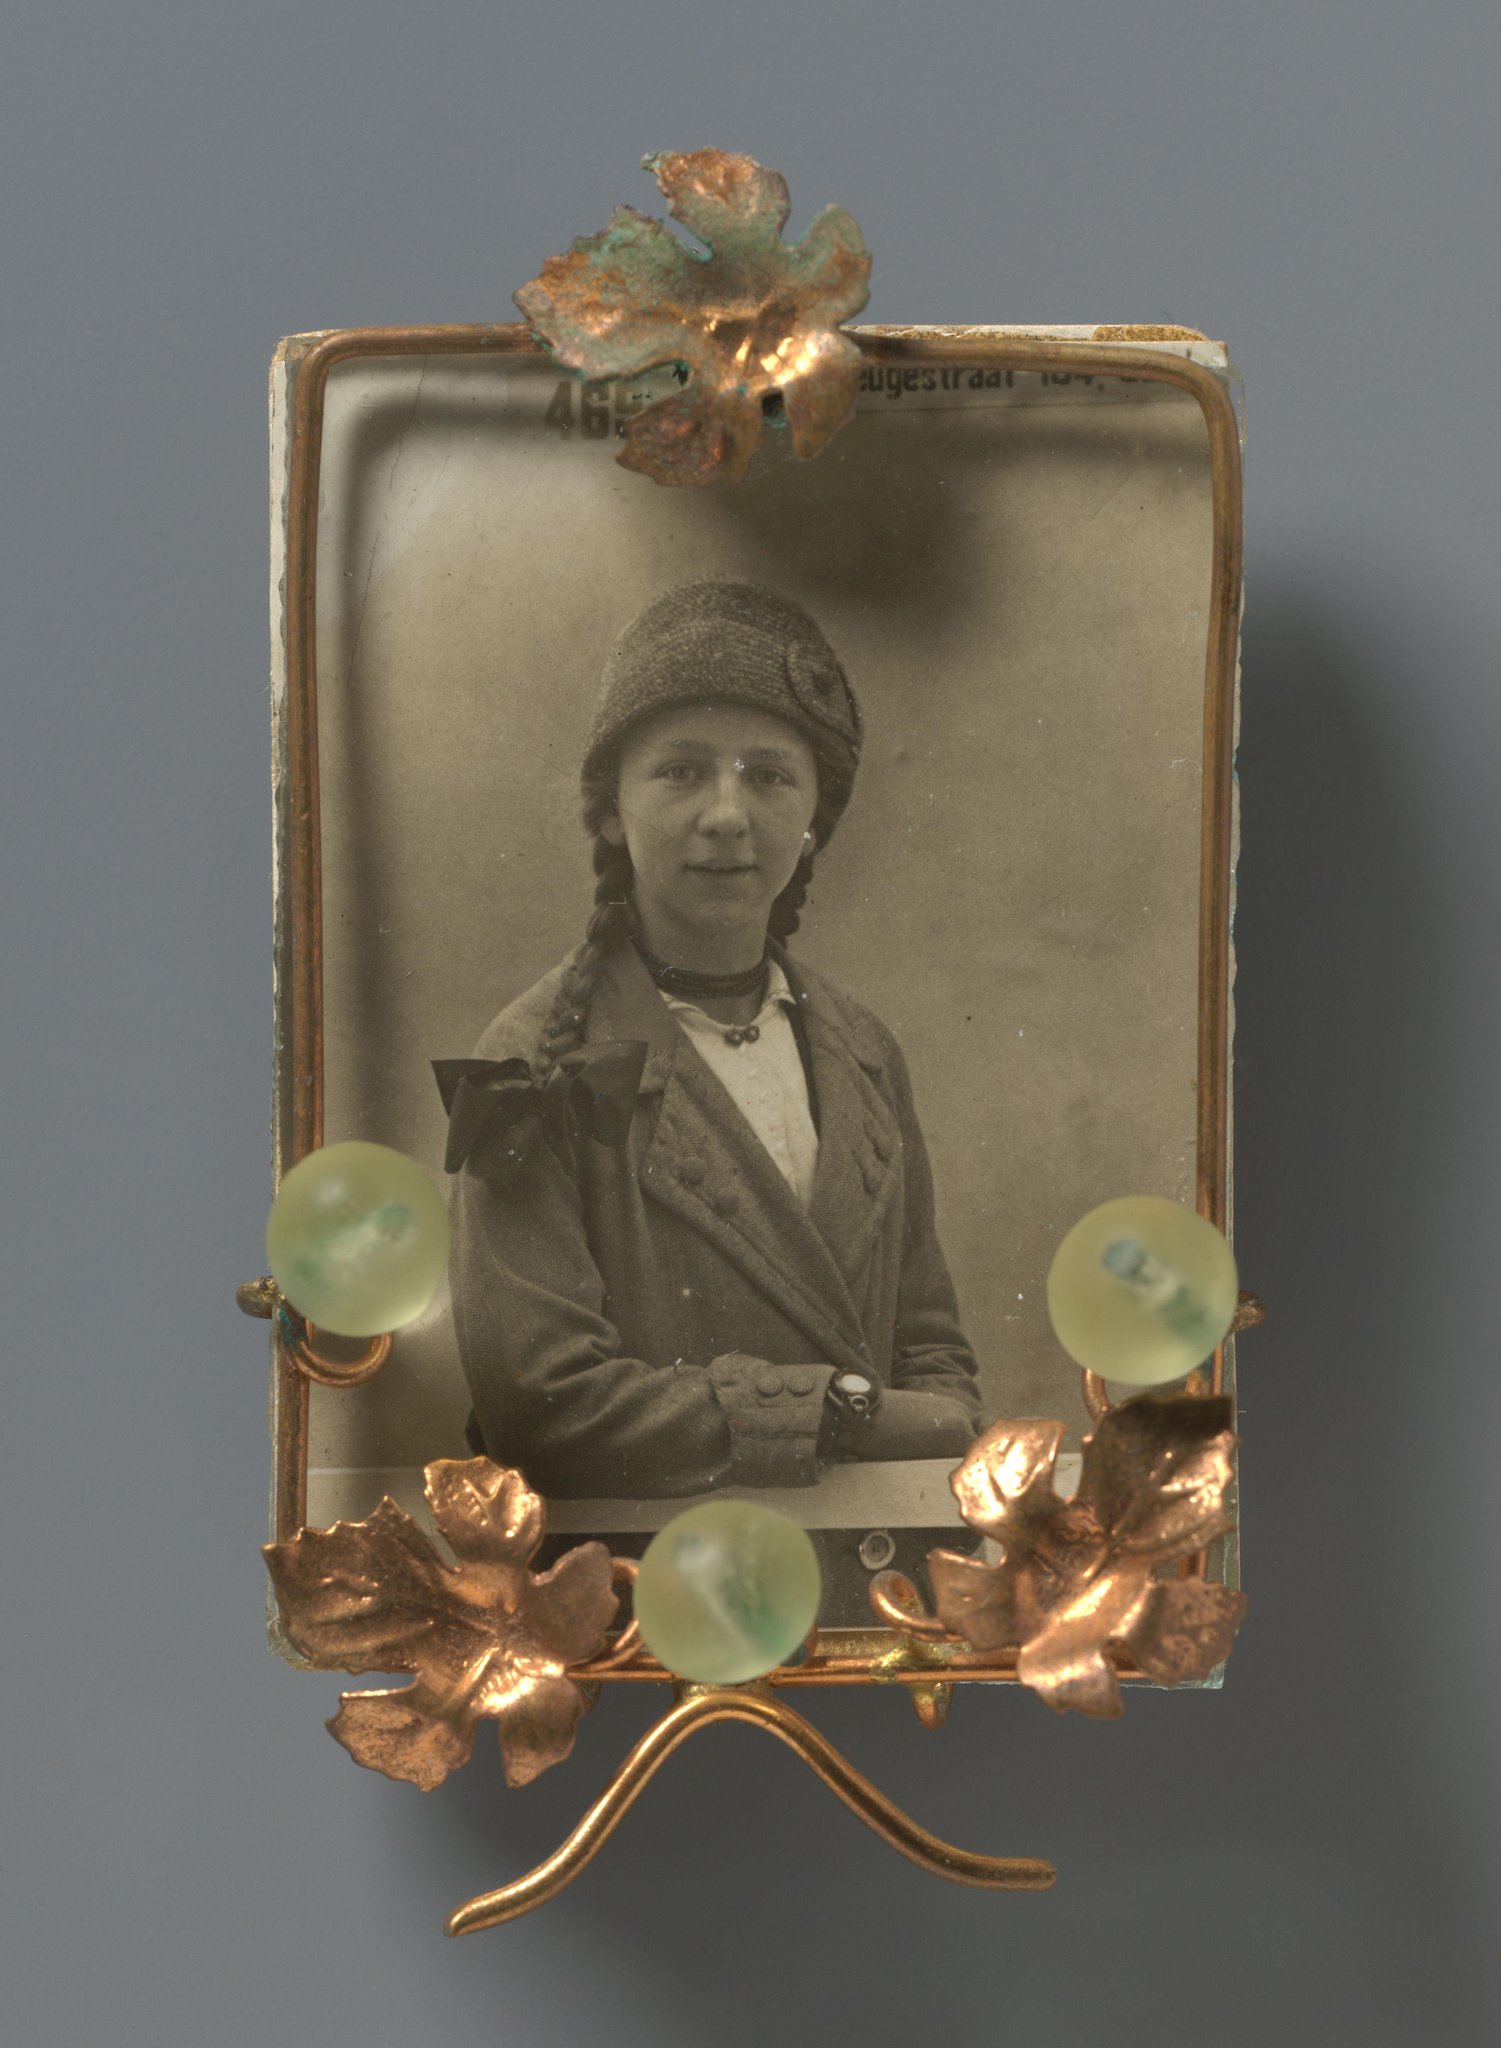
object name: frame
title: Portret van een onbekend meisje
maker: theodorus tukker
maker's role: fotograaf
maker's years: 1891-1967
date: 1915-1925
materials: paper, glass, metal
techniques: gelatin silver print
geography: gouda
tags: anonymous historical person portrayed - bb - woman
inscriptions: address: ‘469 TUKKER. Zeugestraat 104, GOUDA’